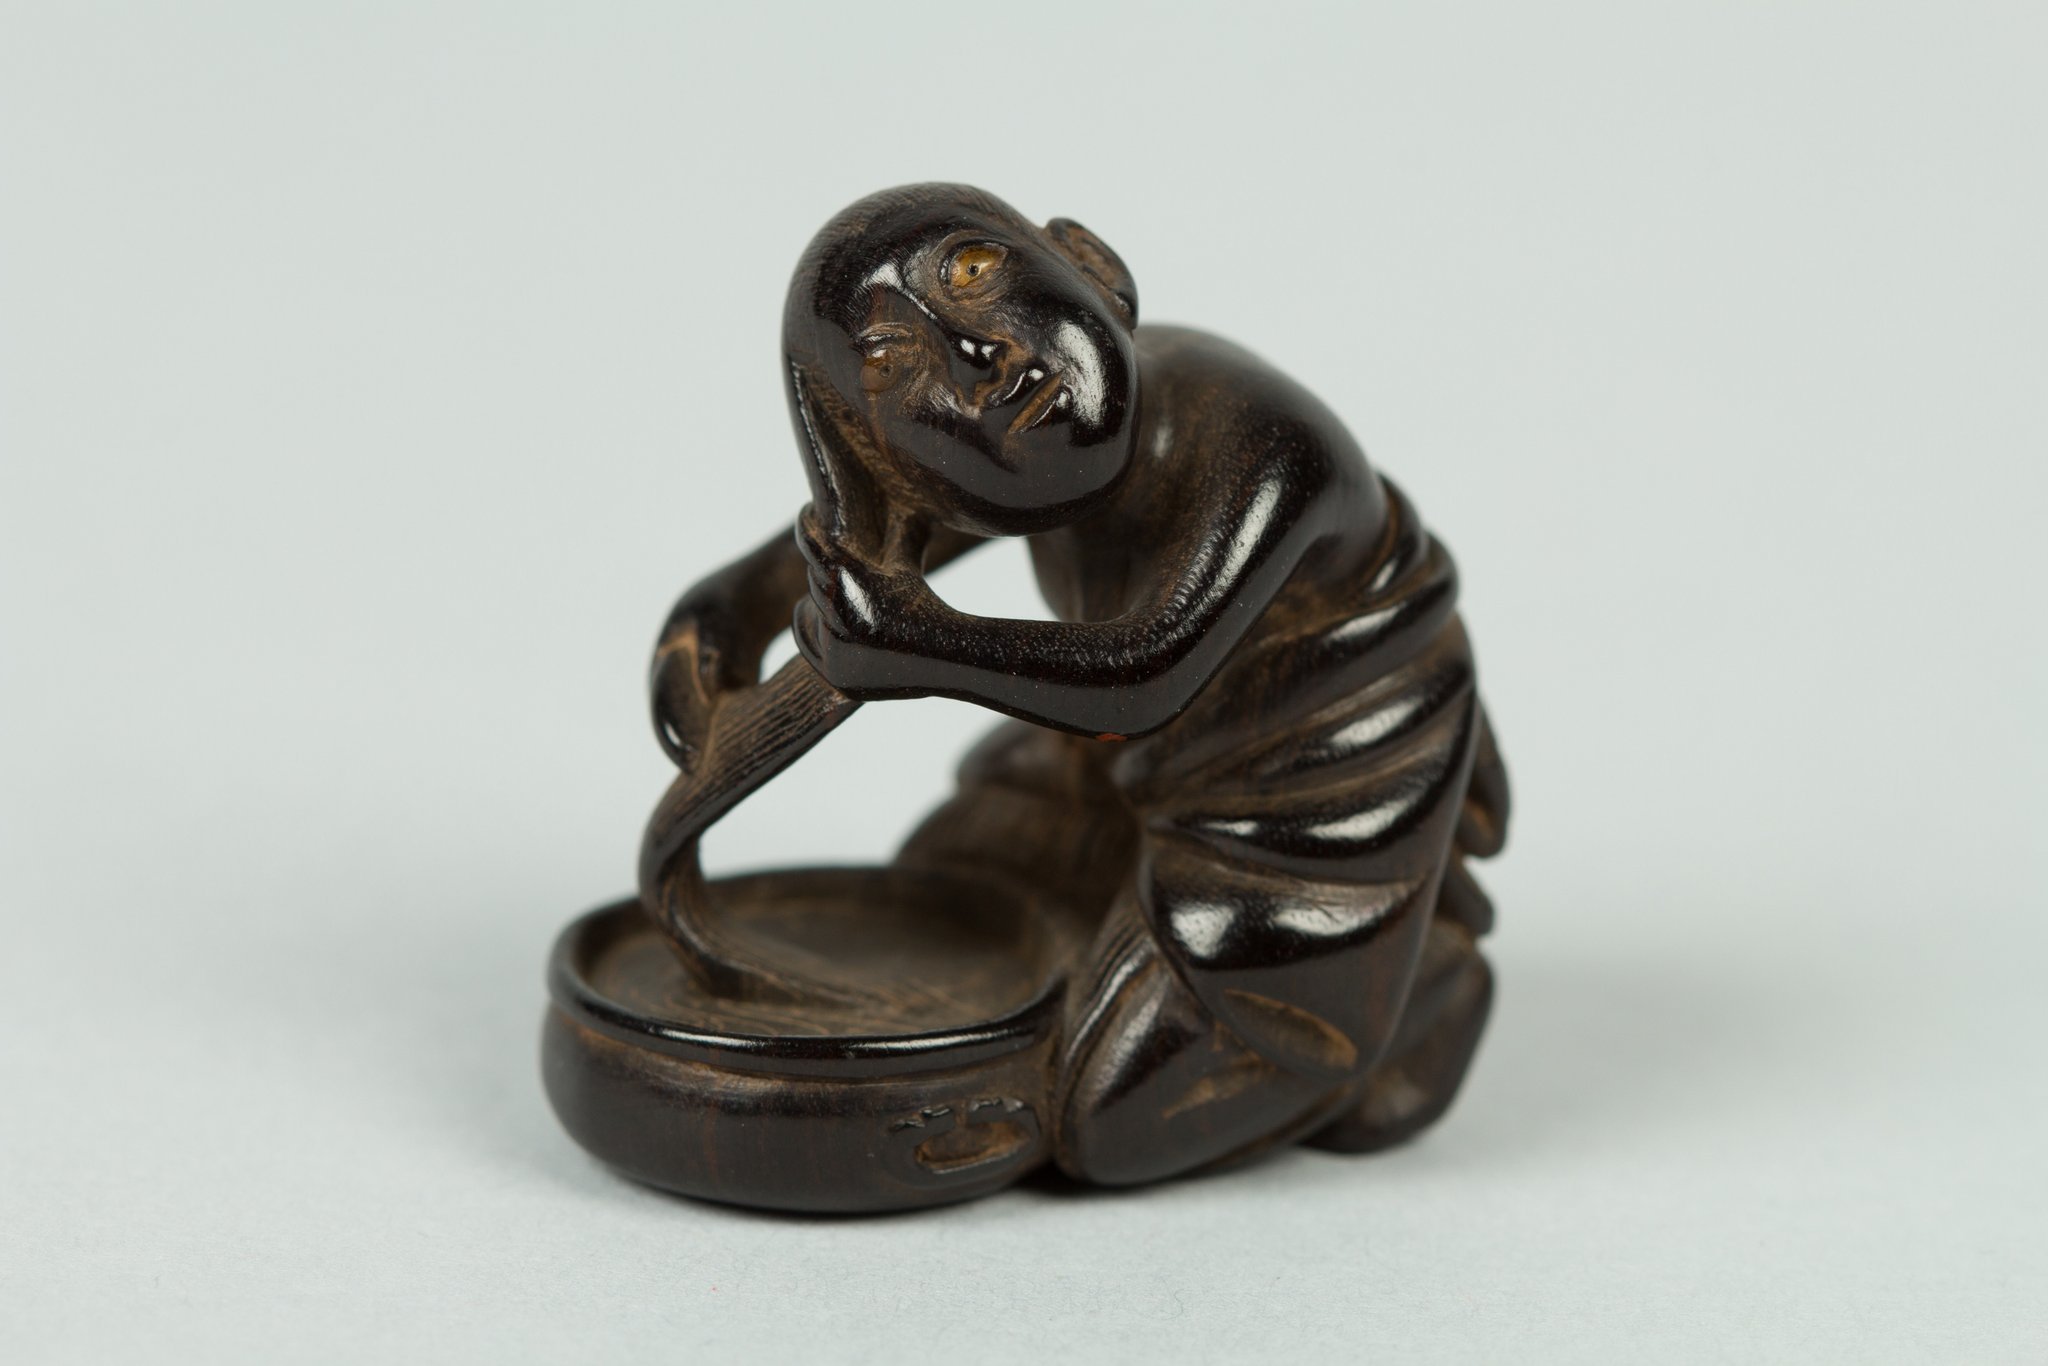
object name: netsuke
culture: japanese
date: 1701-1800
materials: wood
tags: human figures